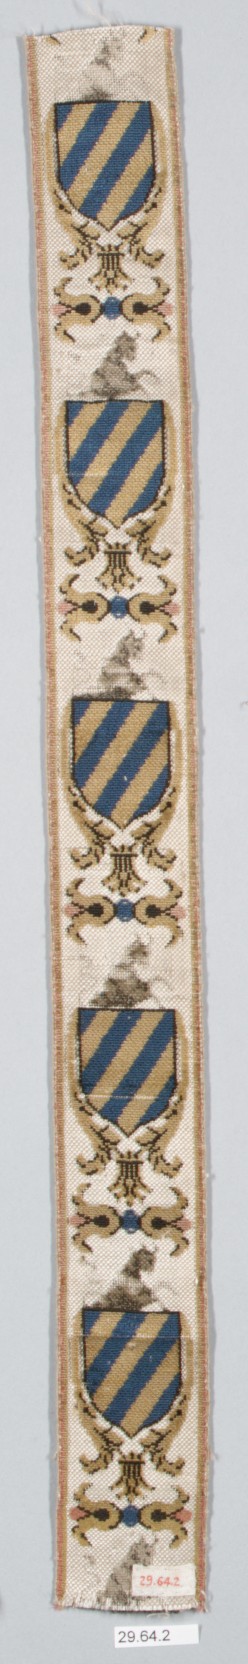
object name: galloon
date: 1701-1900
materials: silk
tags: coat of arms